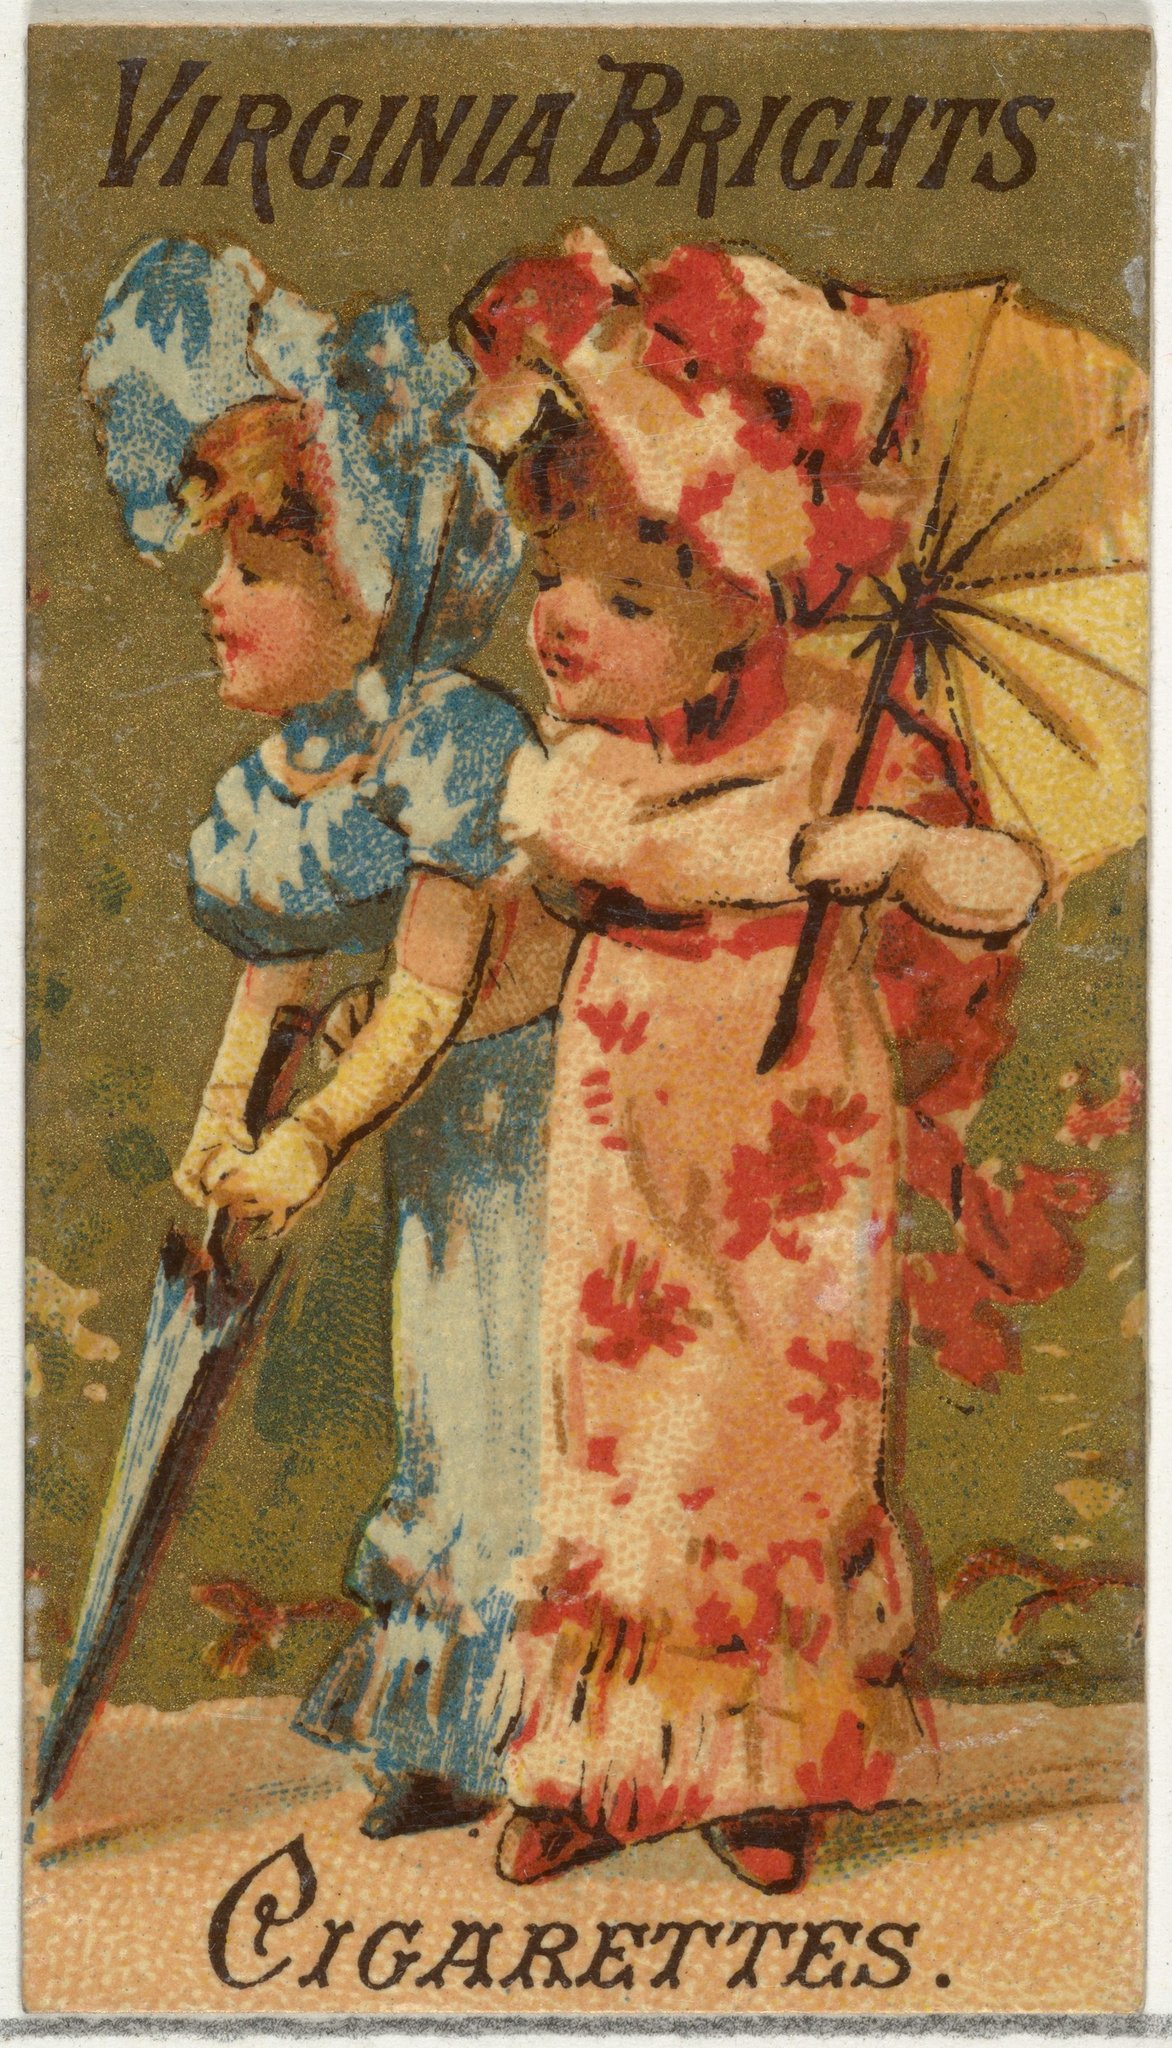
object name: print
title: From the Girls and Children series (N64) promoting Virginia Brights Cigarettes for Allen & Ginter brand tobacco products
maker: allen & ginter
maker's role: publisher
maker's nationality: american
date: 1886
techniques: color lithograph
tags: girls